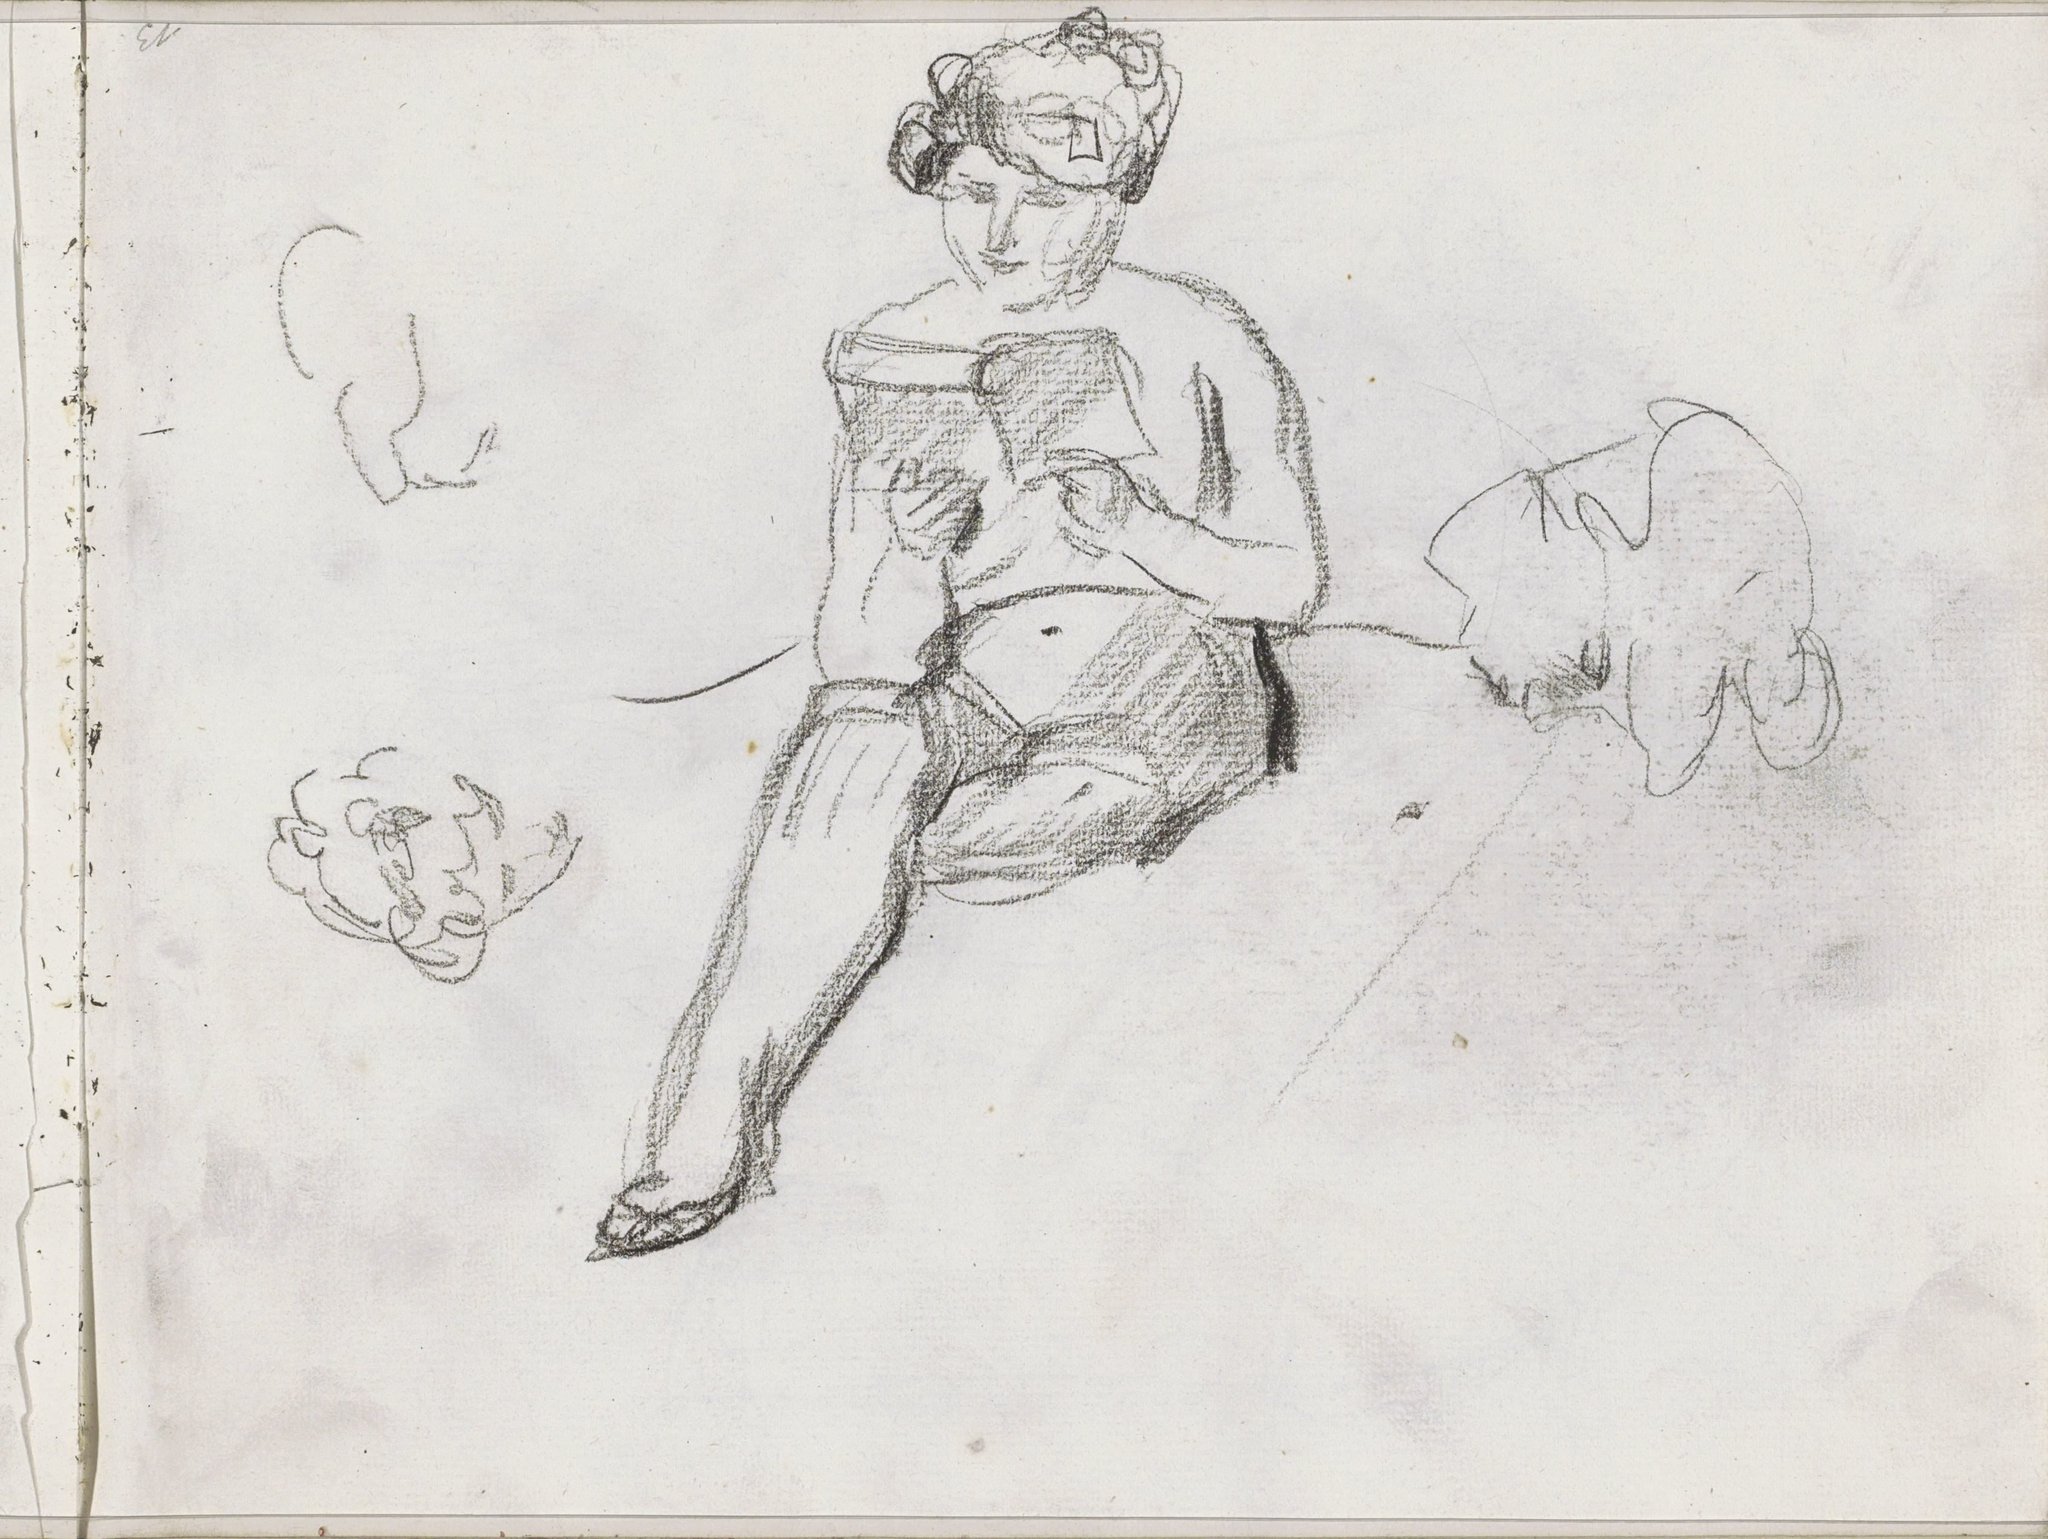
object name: sketchbook leaf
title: Vrouwenhoofden en een lezend vrouwelijk naakt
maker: isaac israels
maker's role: draughtsman, painter, print maker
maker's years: 1865-1934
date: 1875-1934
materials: chalk, paper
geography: the hague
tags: the (nude) human figure; 'corpo humano' (ripa) - aa - female human figure (+ sitting), reading, head (human) - aa - female human figure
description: Blad 19 recto uit schetsboek XXII met 30 bladen.